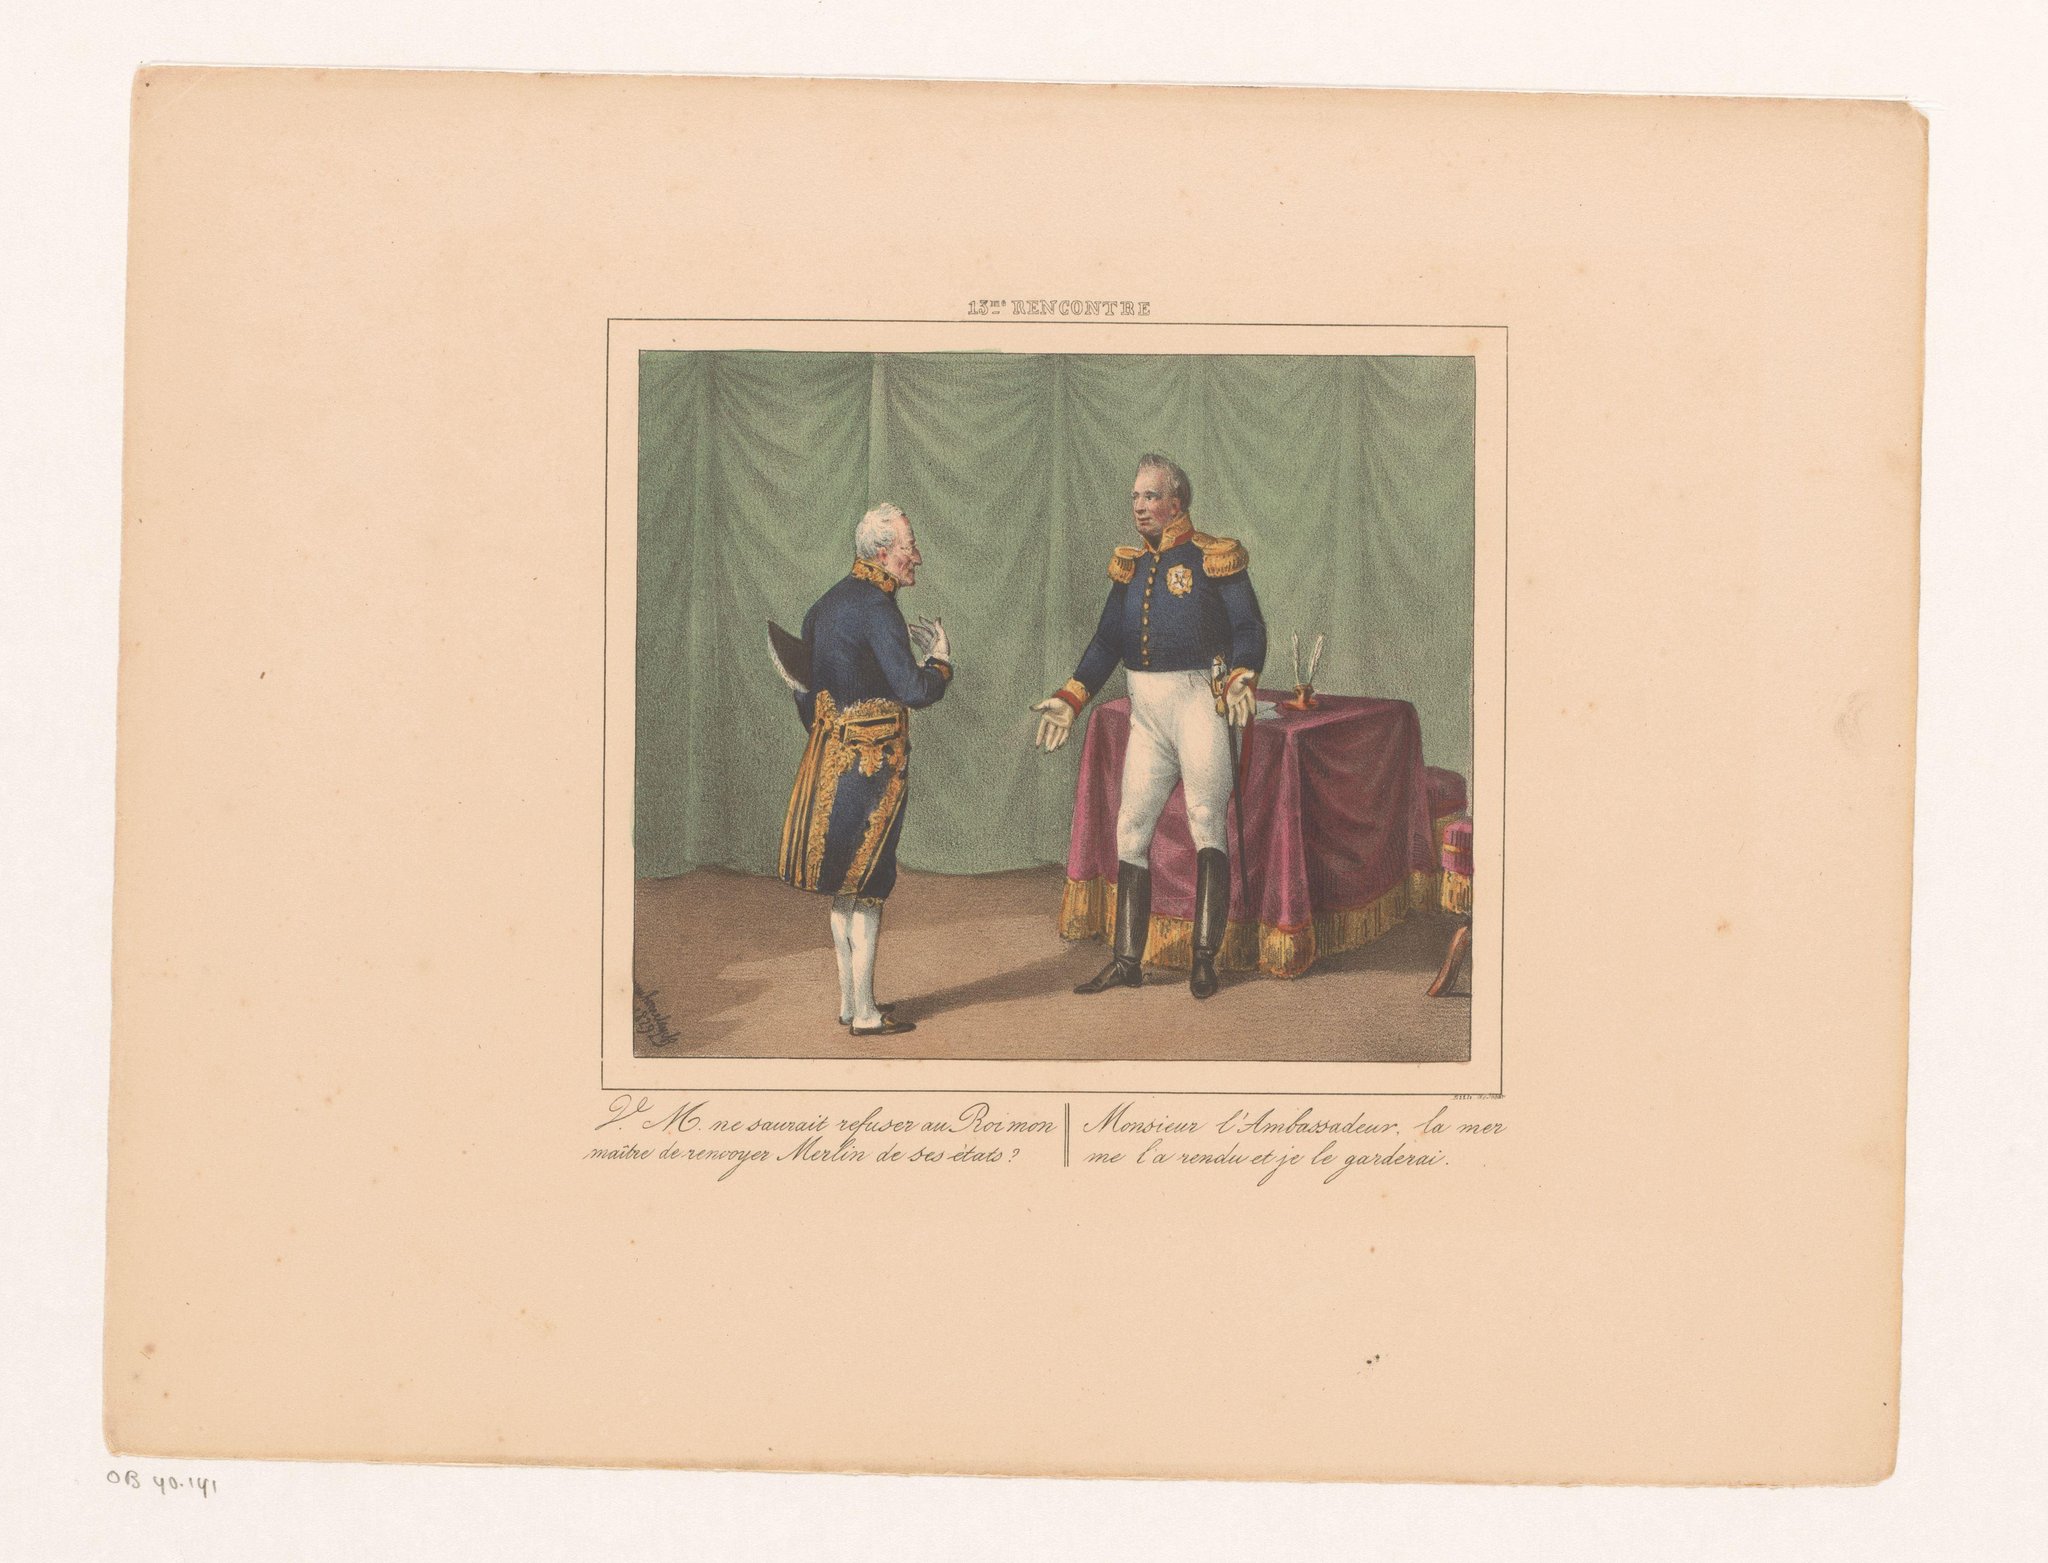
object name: print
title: Koning Willem I slaat het verzoek om uitlevering van Merlin af, 1829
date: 1829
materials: paper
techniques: hand coloring, lithograph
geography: brussels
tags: the hague, berlin, william i of the netherlands, paris, politician, ambassador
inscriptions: collector's mark: Lugt 2228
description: De koning slaat het verzoek van de Franse ambassadeur om de uitlevering van Merlin aan Frankrijk af met de woorden 'La mer me l'a rendu ... Je le garde'. Met vierregelig onderschrift. Onderdeel van de serie van 24 platen met ontmoetingen met koning Willem I, verschenen onder de titel 'Les rencontres' in 1829-1830.